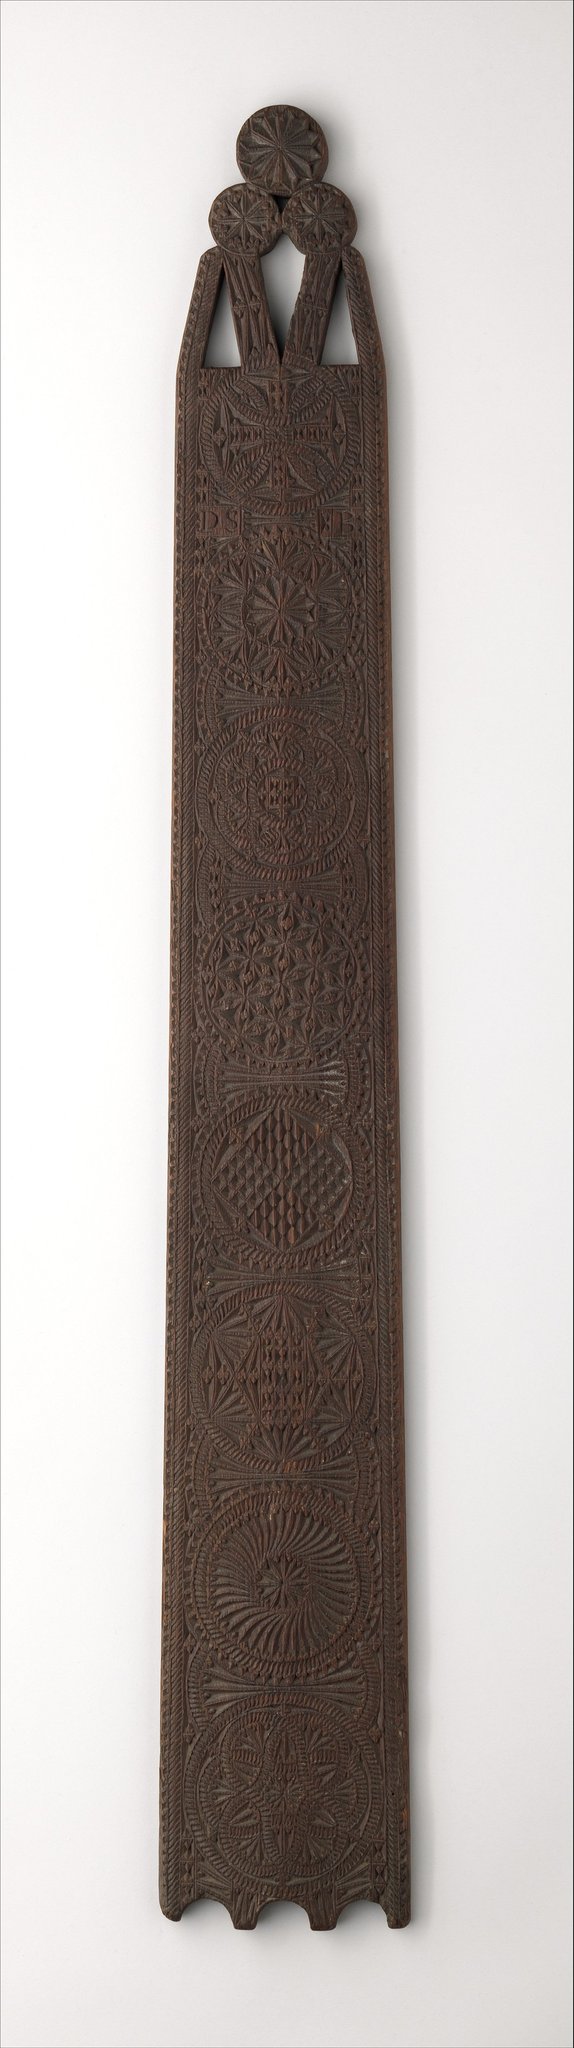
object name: mangle board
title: Mangle-board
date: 1701-1800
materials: wood